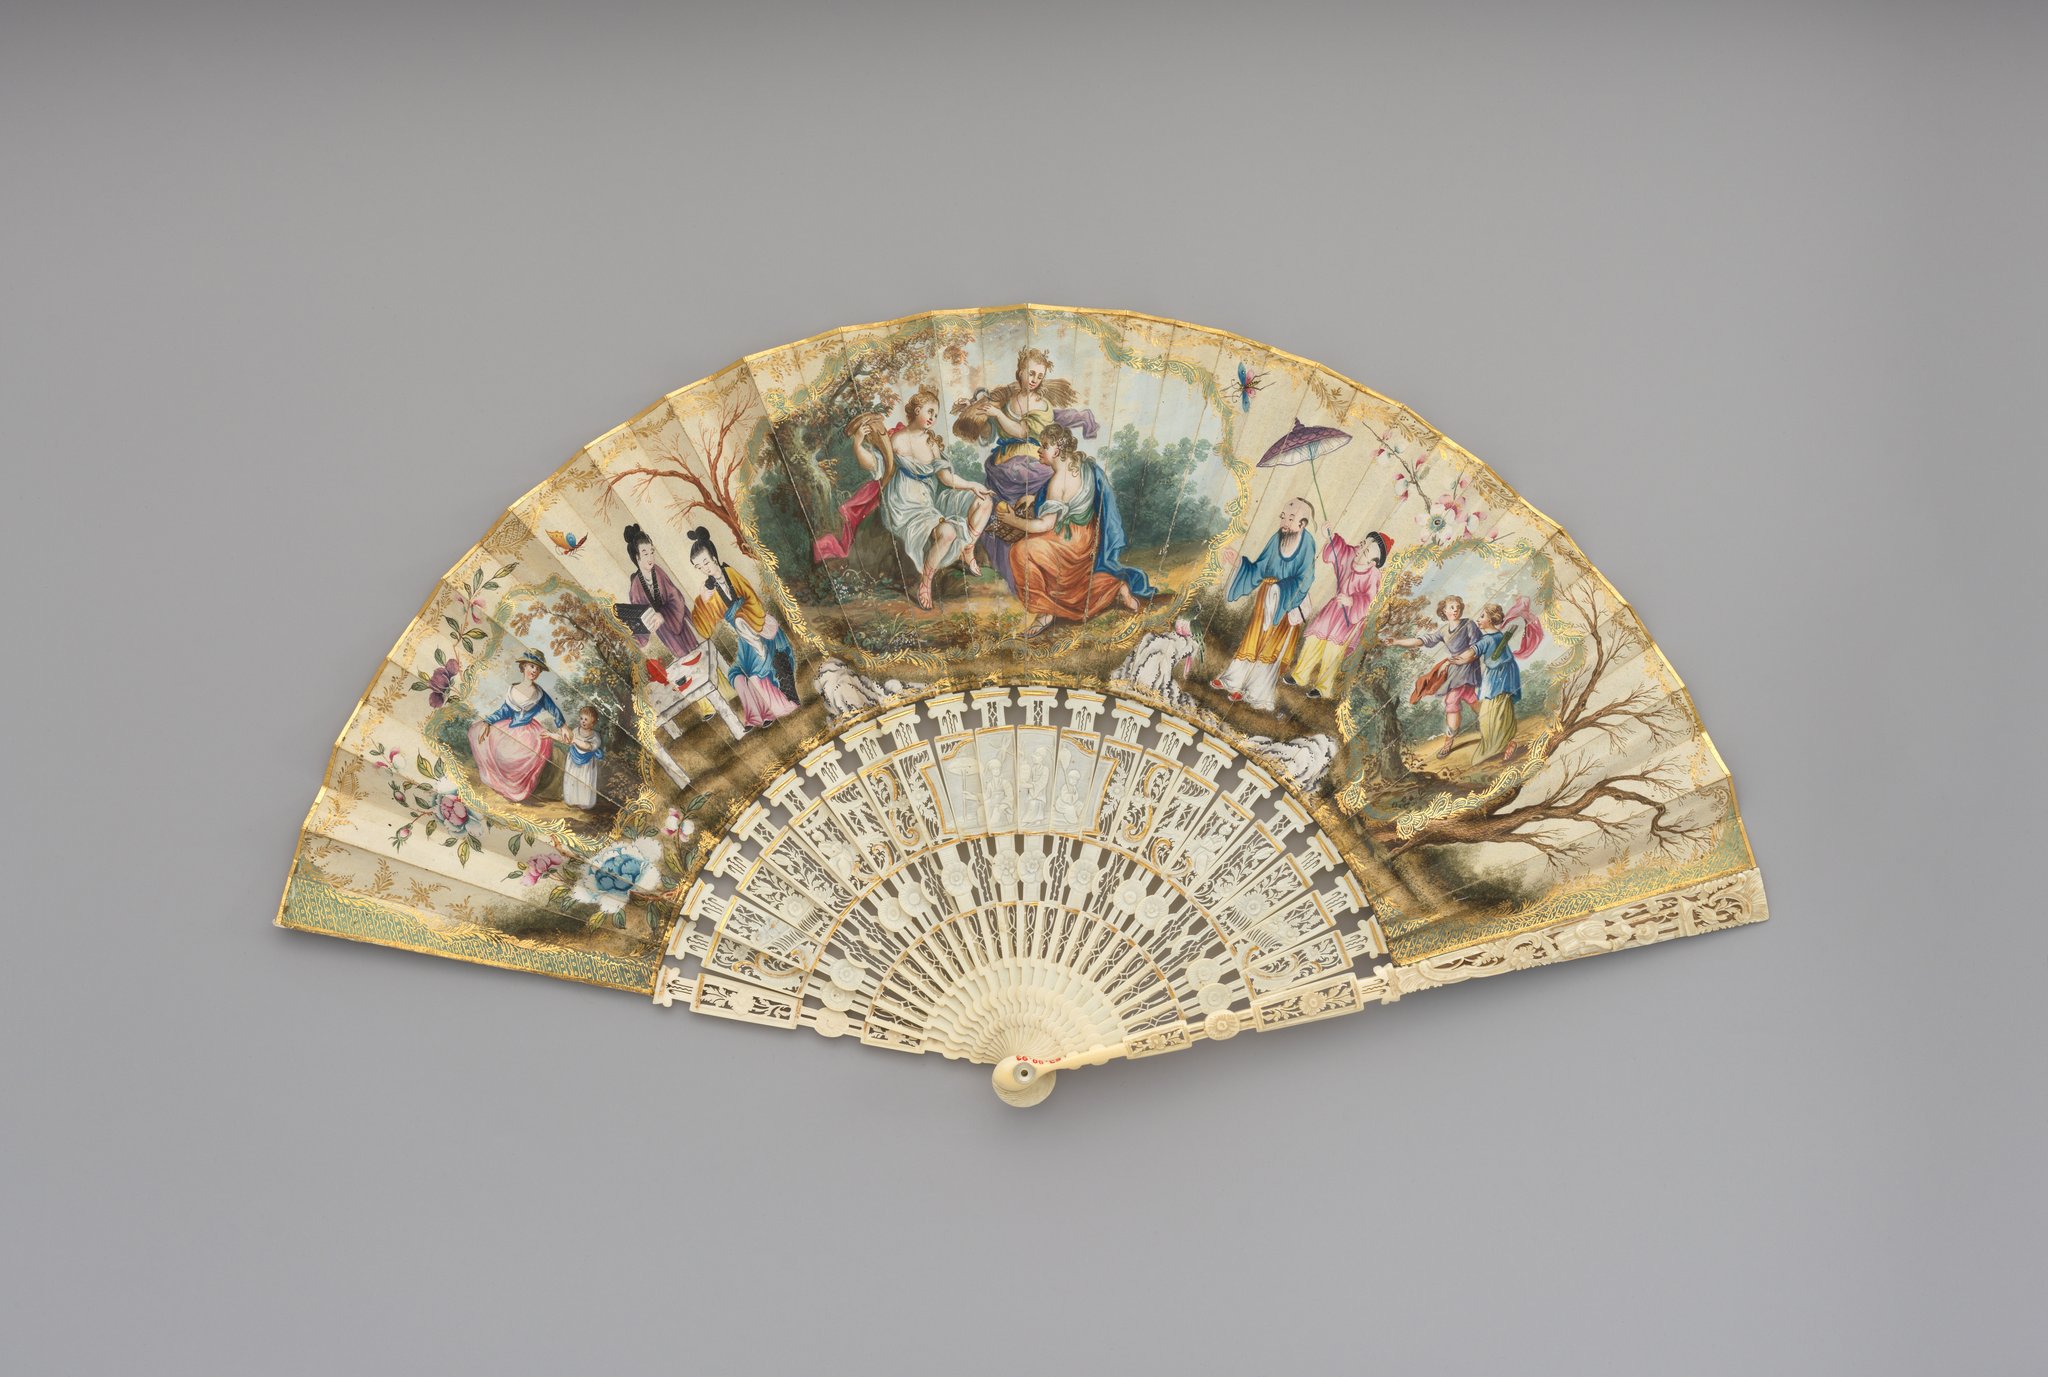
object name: fan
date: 1701-1800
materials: ivory, paper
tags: men,women